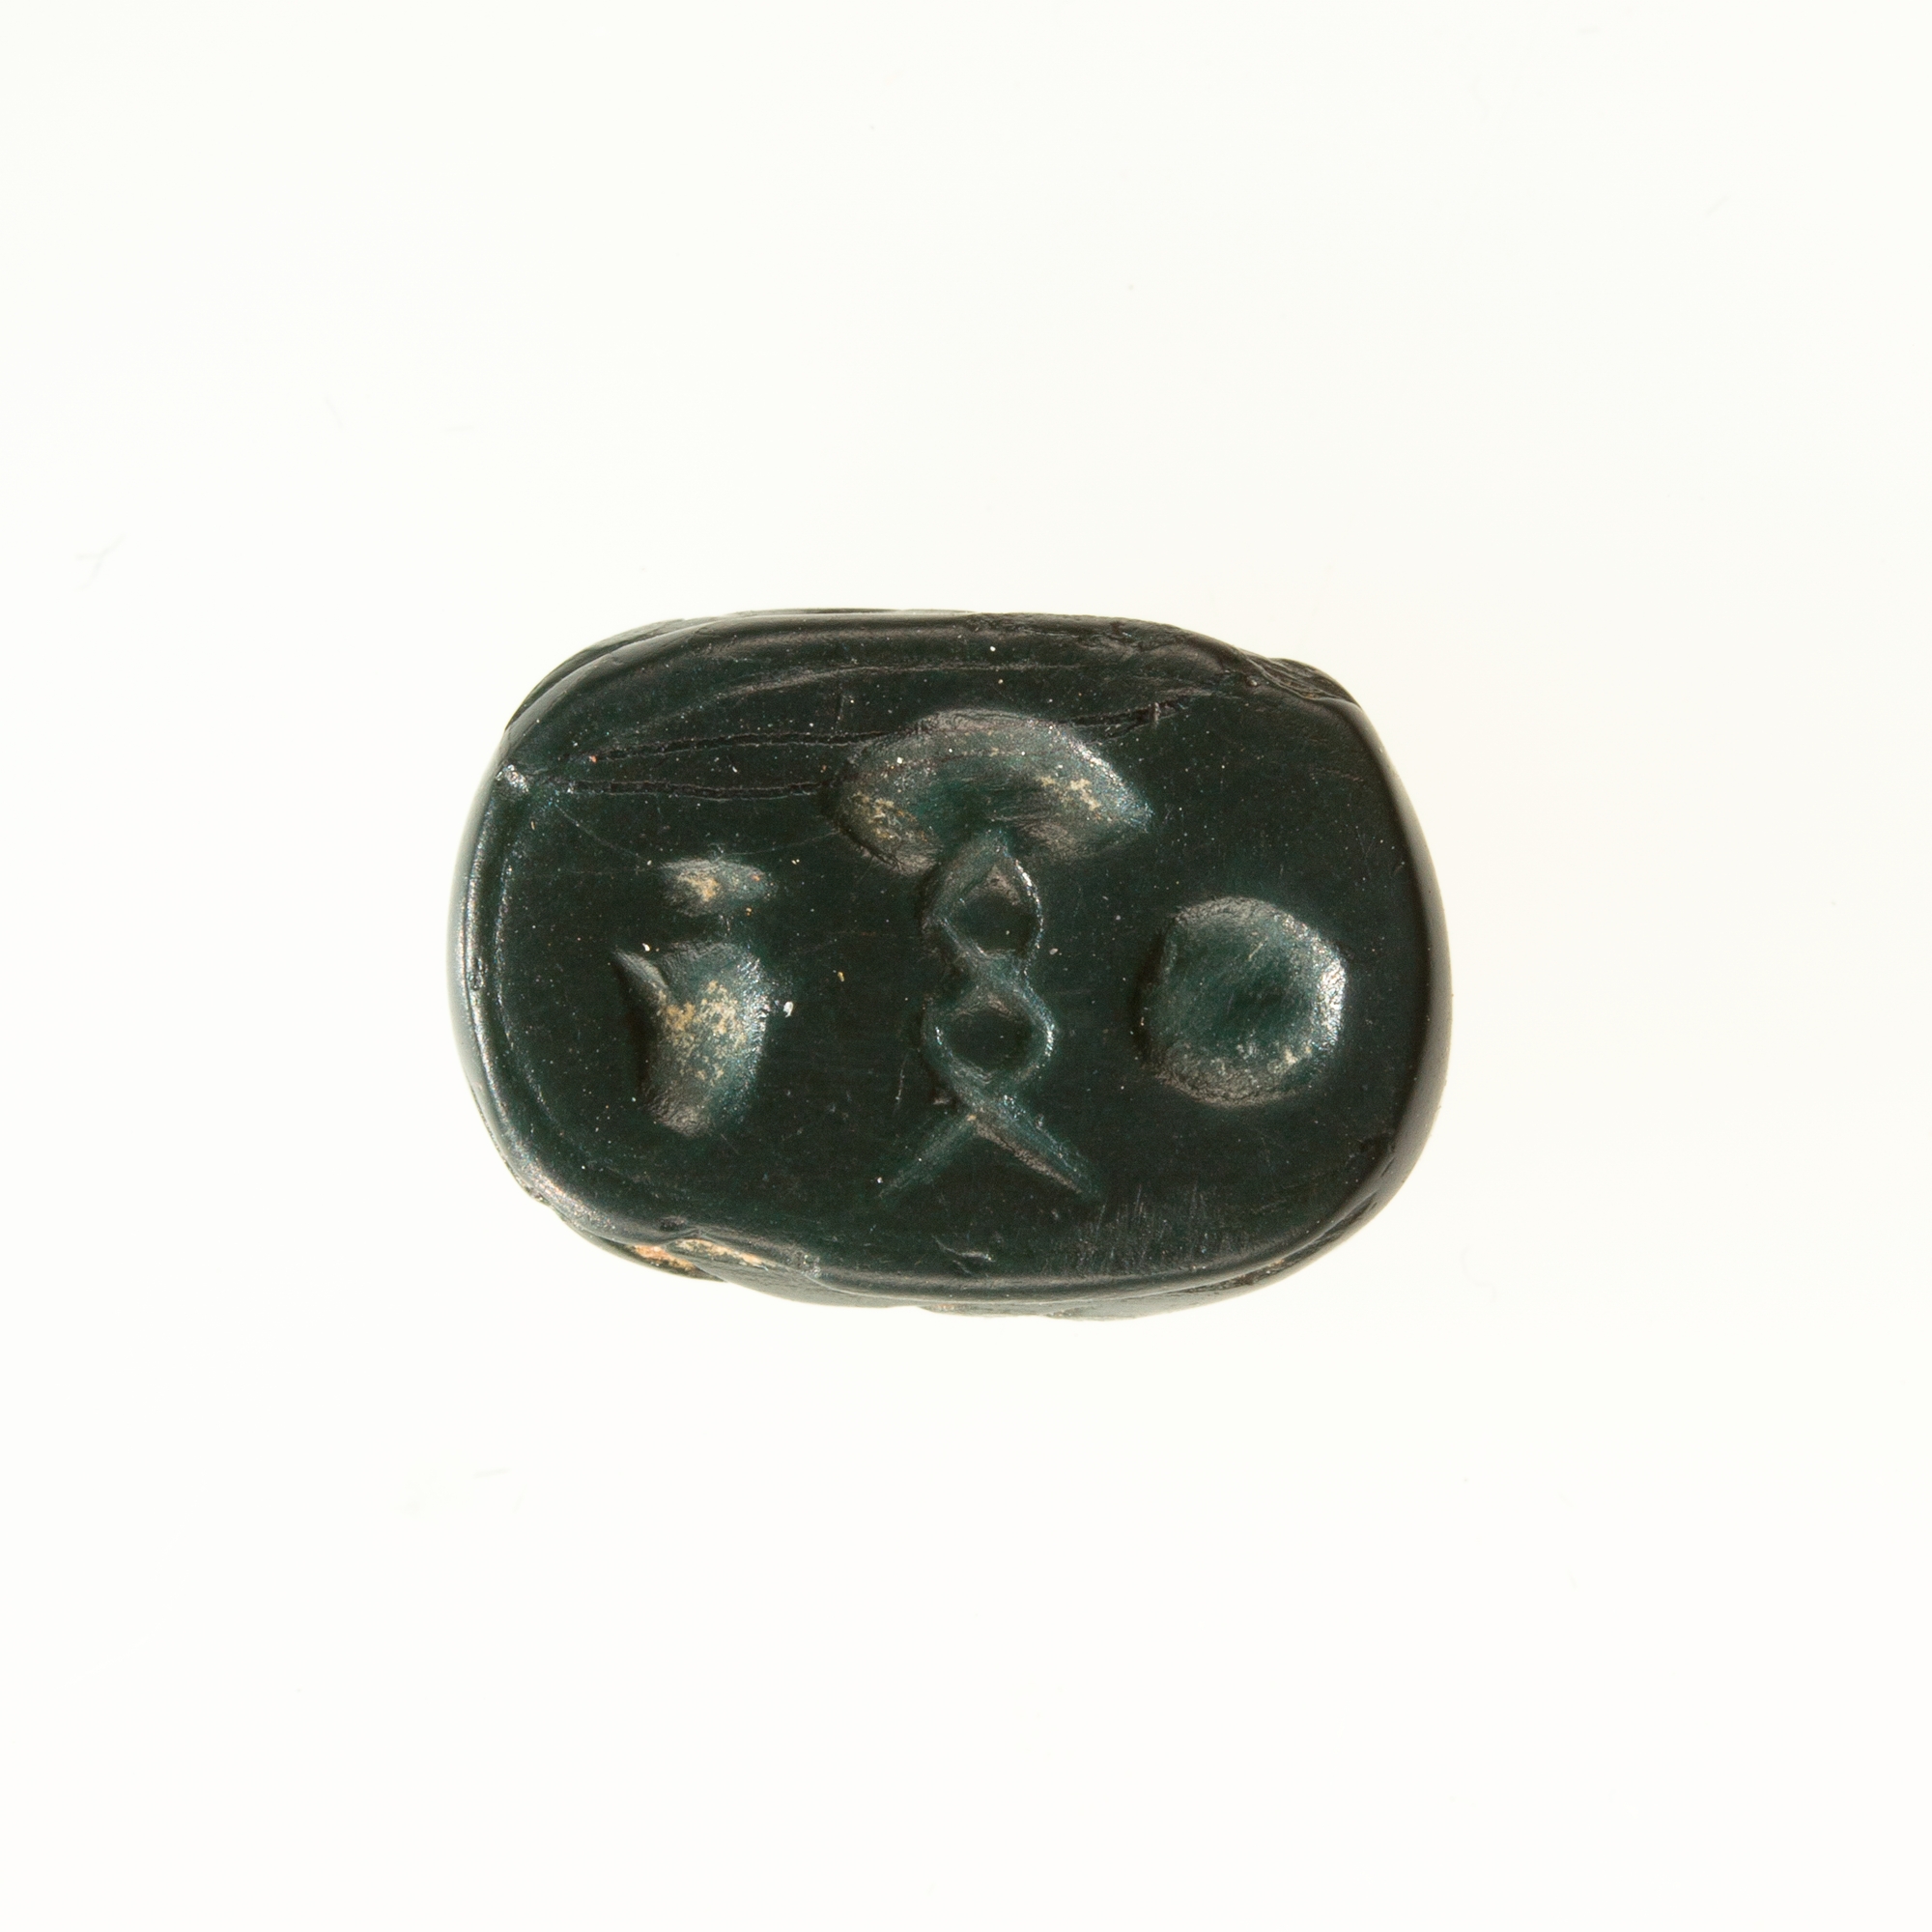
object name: scarab, wahibre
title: Scarab with the name Wahibre, either Psamtik I or Apries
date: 664-570 BCE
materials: mineral, onyx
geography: egypt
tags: scarabs